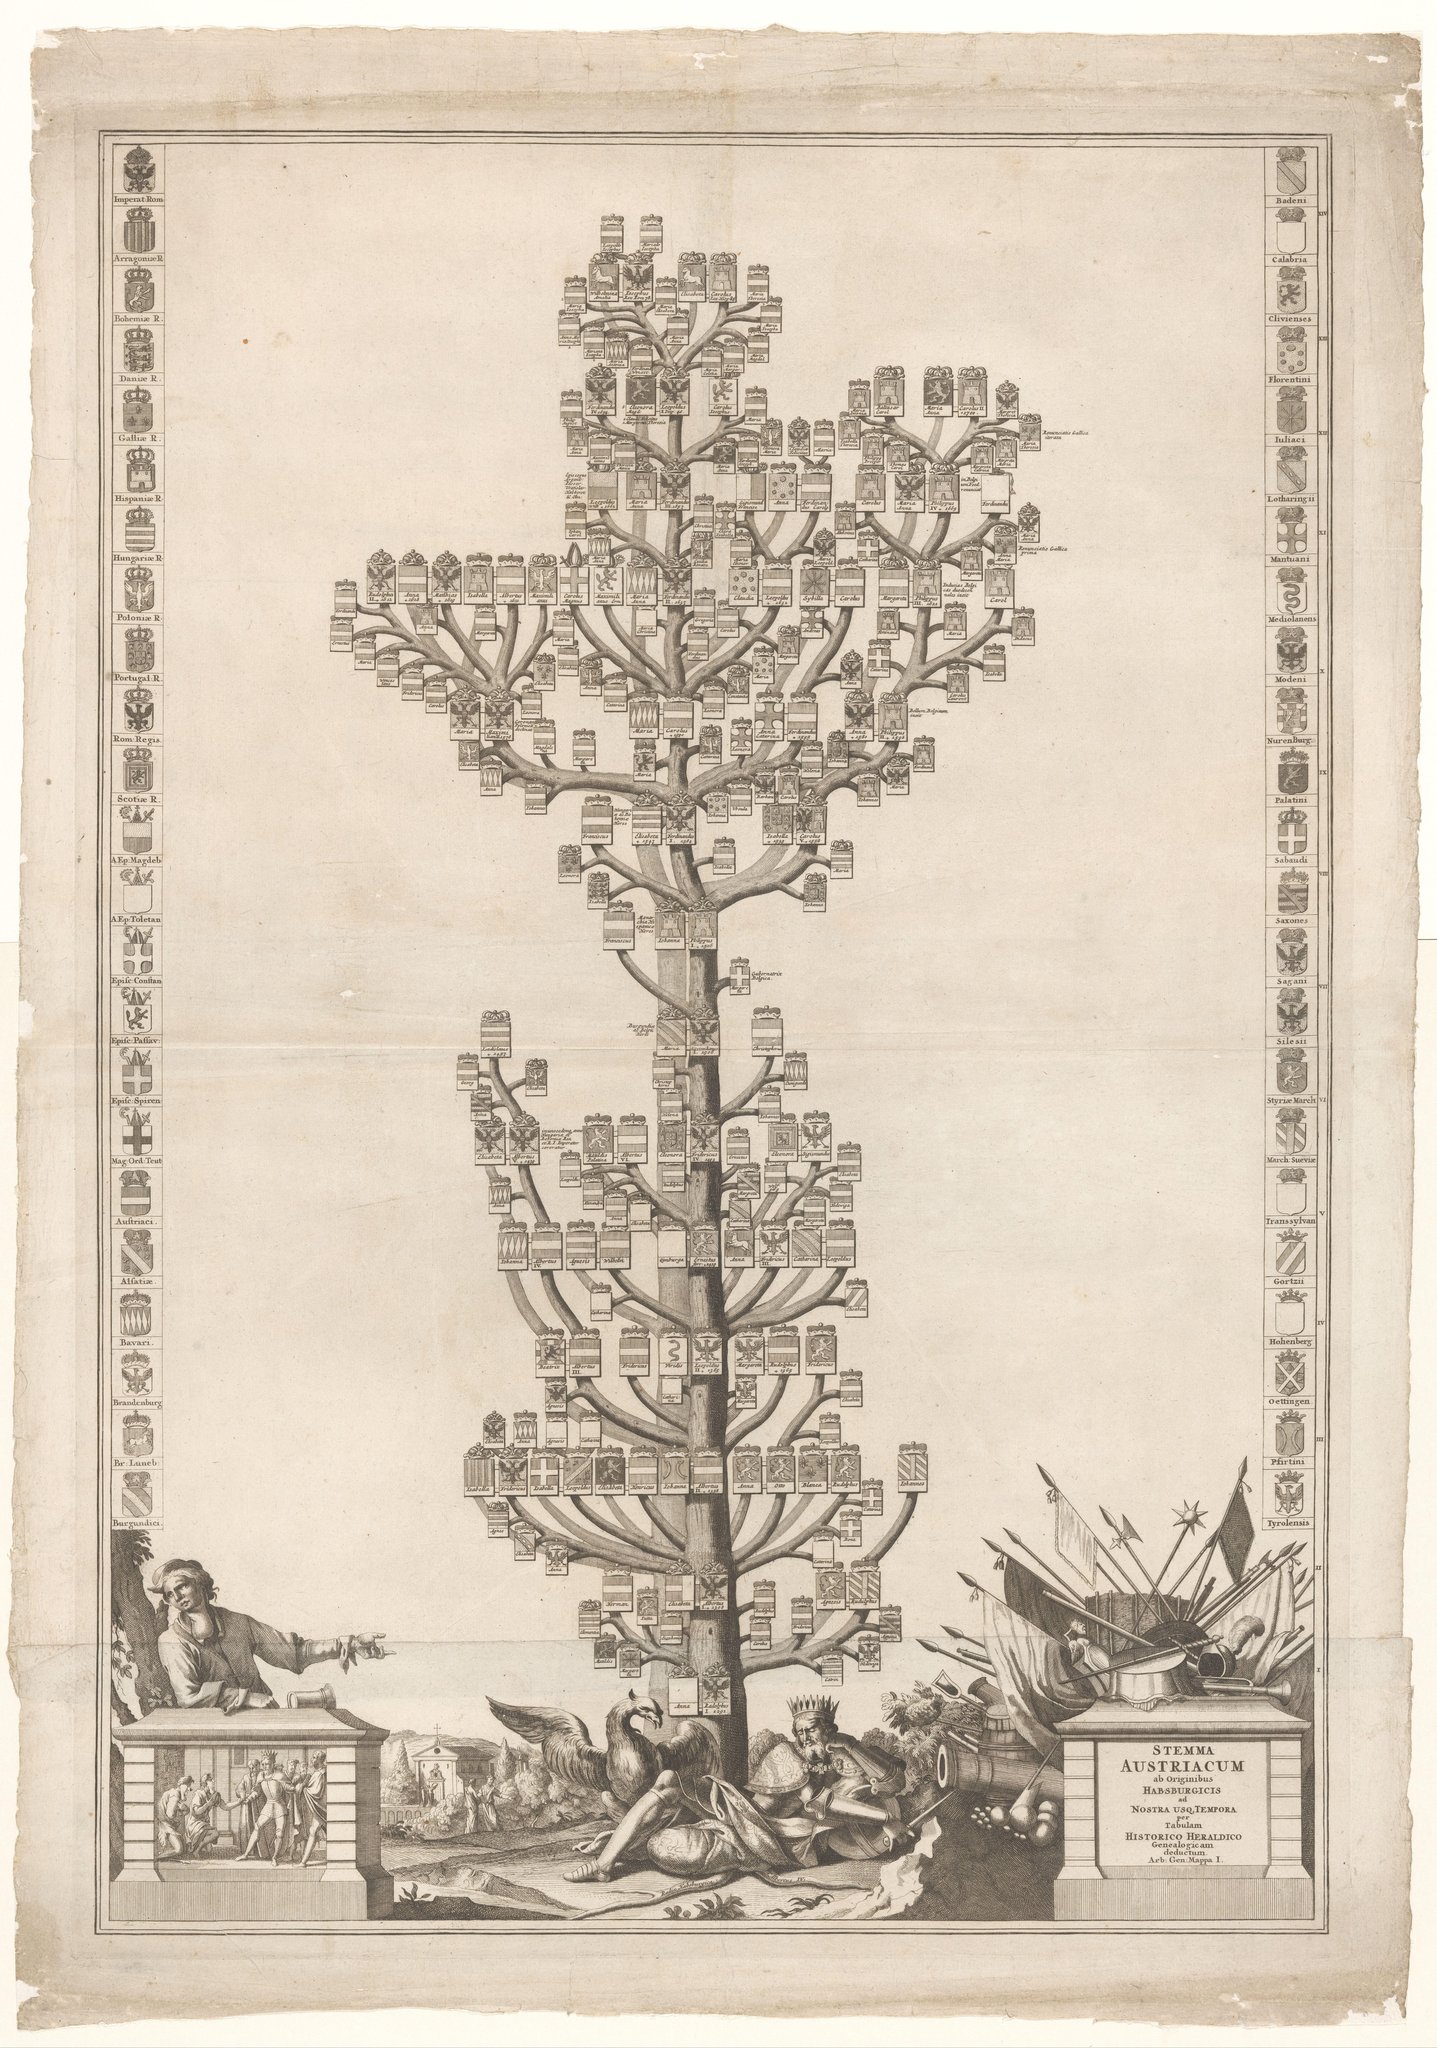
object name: print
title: Stamboom van het Habsburgse Huis, 1291-1710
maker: Anonymous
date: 1710-1745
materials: paper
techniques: engraving, etching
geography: netherlands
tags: family lineage, pedigree, genealogical tree or table, series of rulers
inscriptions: collector's mark: Lugt 2228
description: Mogelijk afkomstig uit: [J.W. Schele] Verzamelde mengelstoffen, verscheide Geschicht en Geslagtkundige aanmerkingen aantoonende, in kopere platen verbeeld / door een liefhebber der Geschiedenissen, Haarlem : J. Marshoorn, 1745.